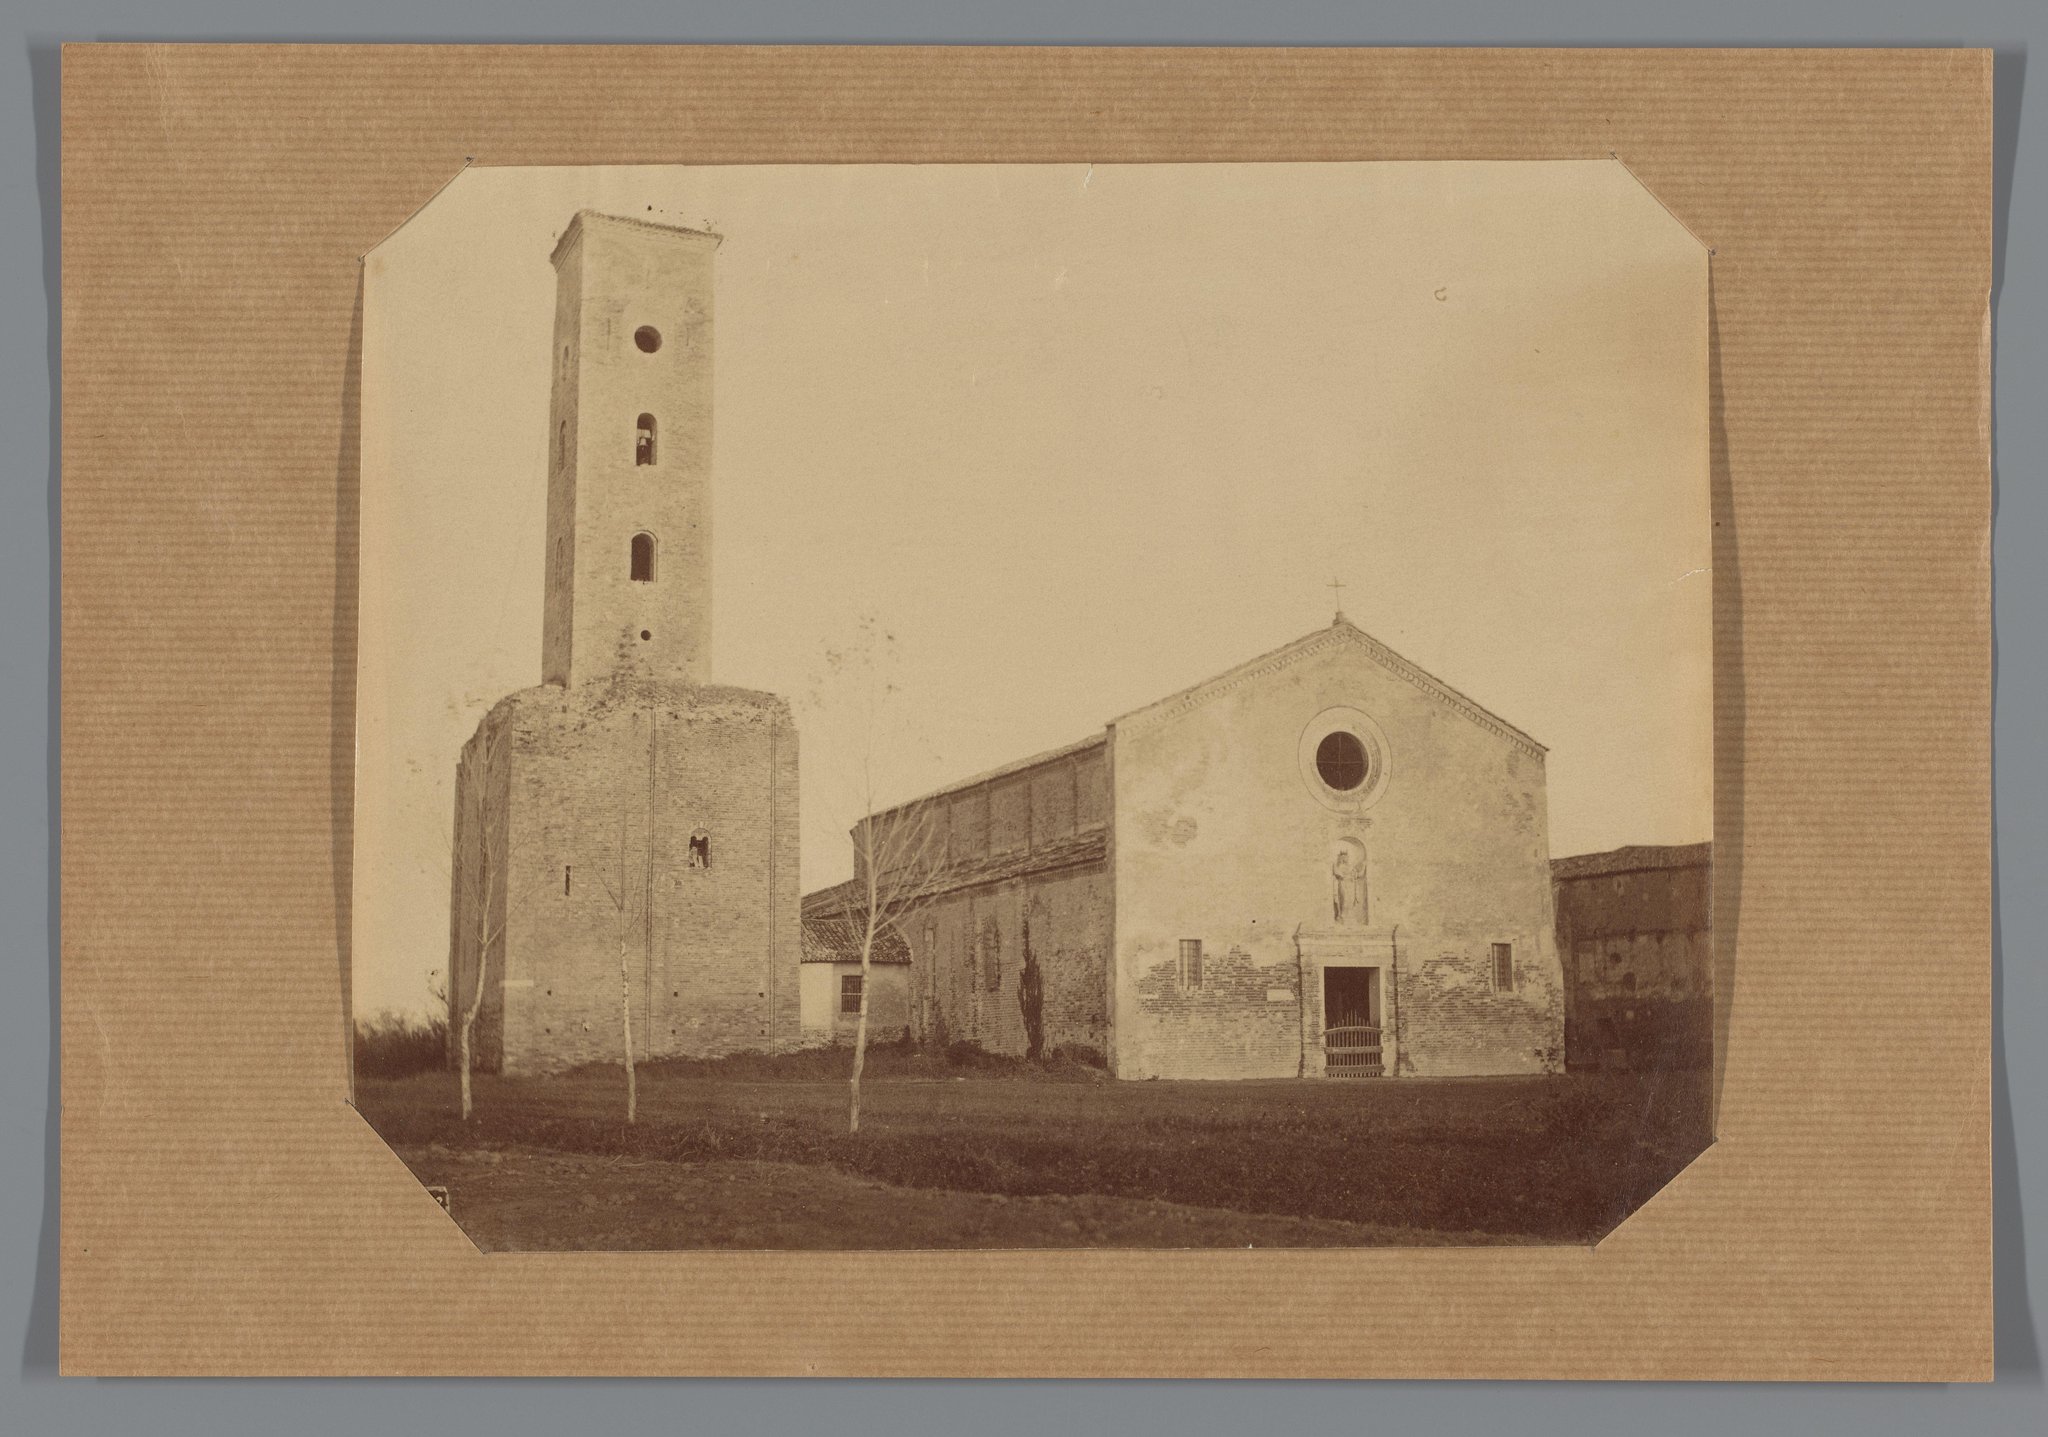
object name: photograph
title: Italië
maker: Anonymous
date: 1880-1910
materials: photographic support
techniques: albumen print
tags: italy